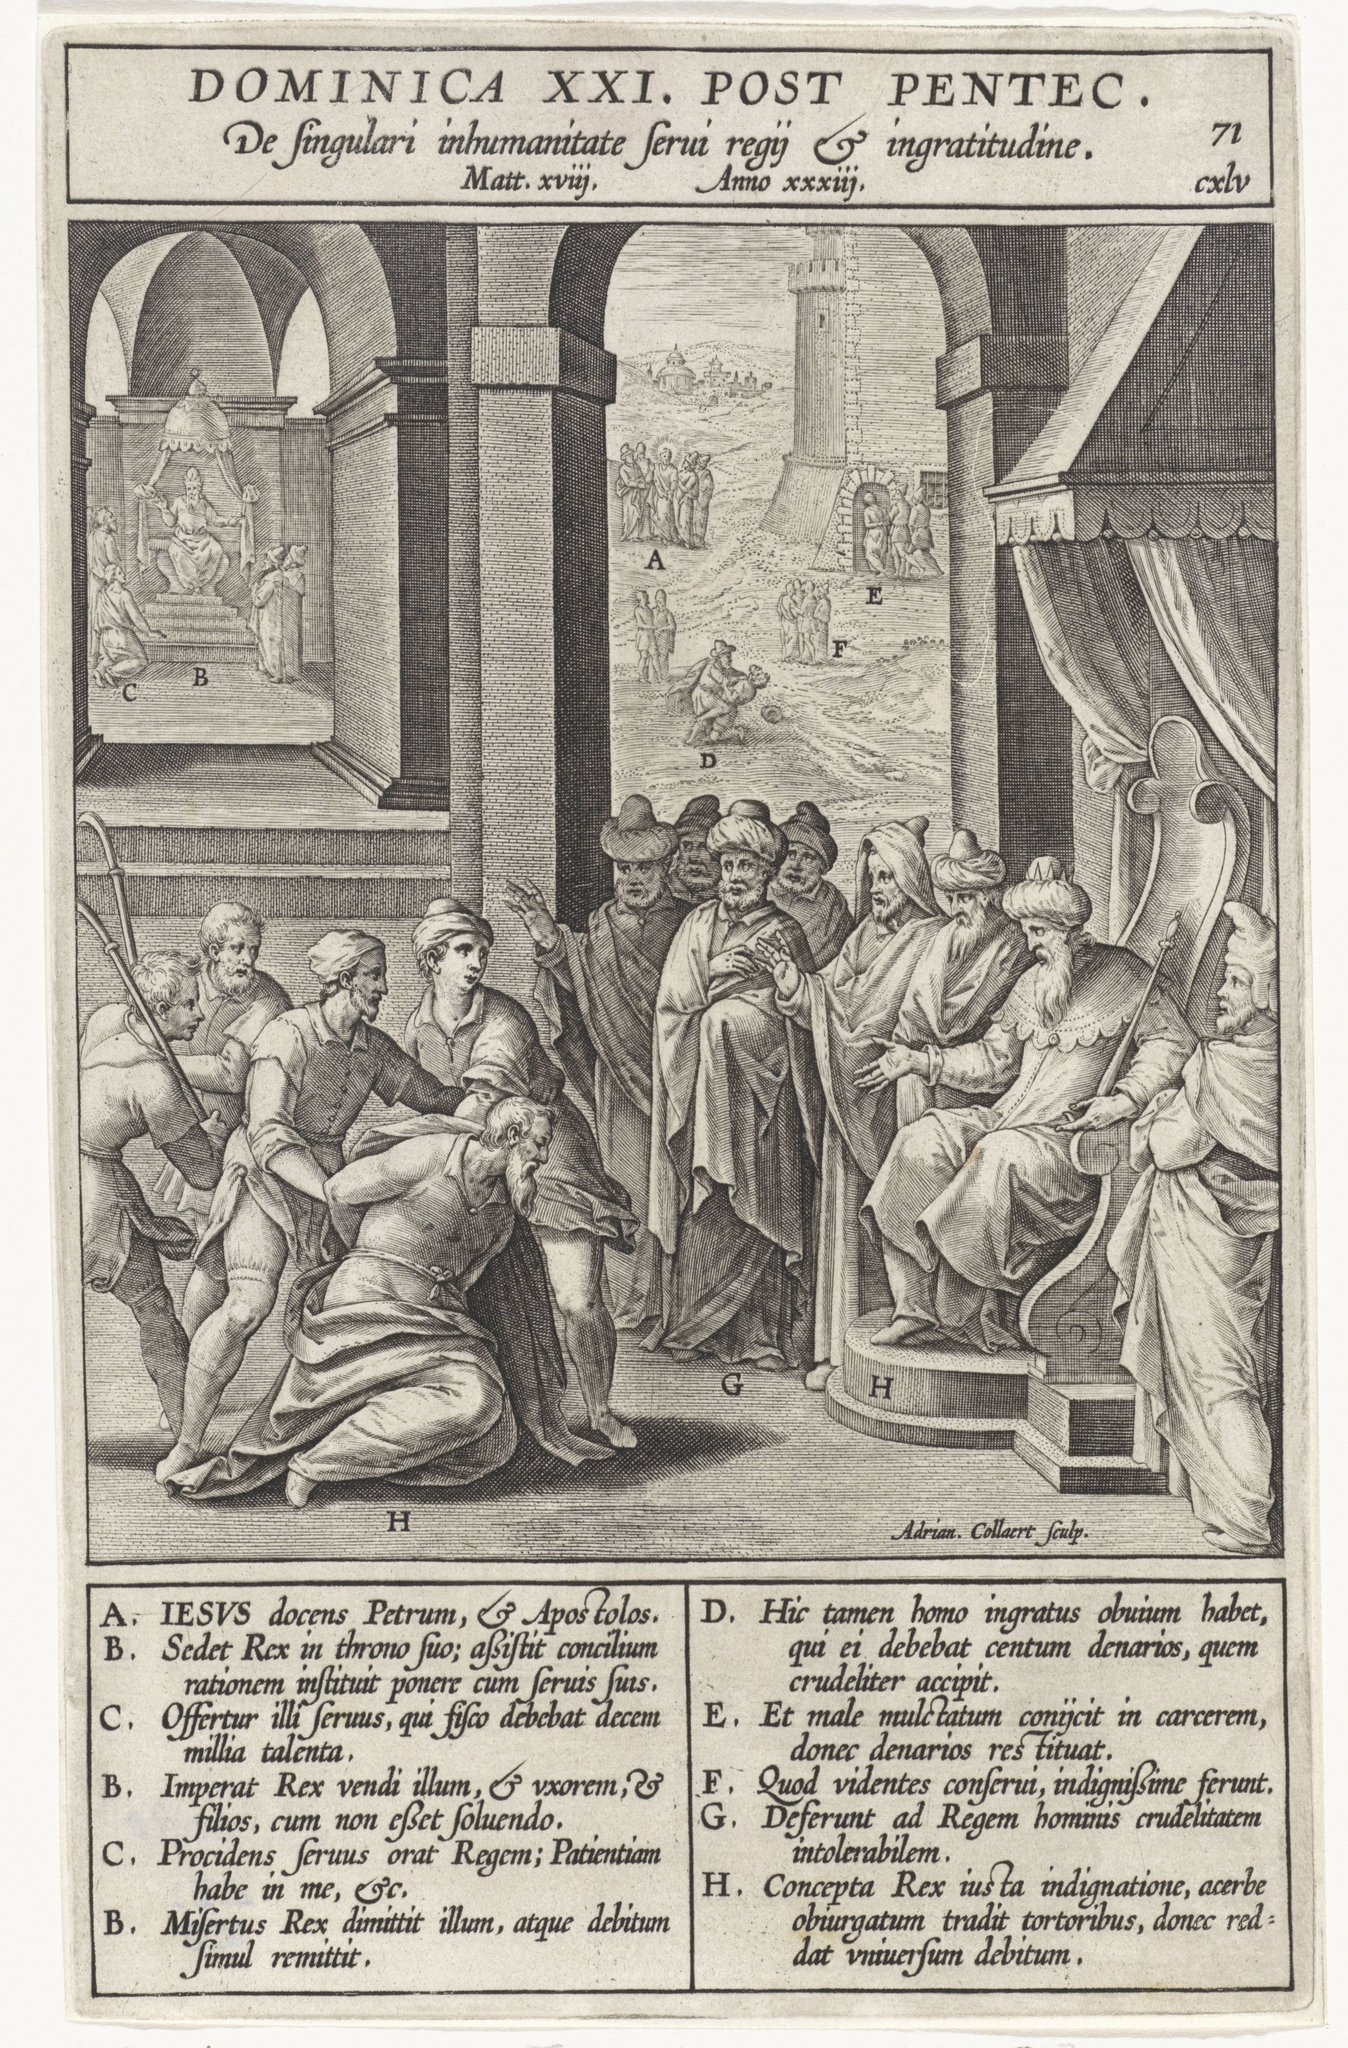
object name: print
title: Dominica XXI. Post Pentec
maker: adriaen collaert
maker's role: draughtsman, print maker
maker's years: 1560-1618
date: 1593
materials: paper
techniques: engraving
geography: antwerp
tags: the unmerciful servant: the king forgives him his debts ~ parable of christ (matthew 18:23-35)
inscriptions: collector's mark: Lugt 2165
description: De ondankbare dienstknecht knielt voor de koning en smeekt hem om hem meer tijd te geven om zijn schuld terug te betalen. De koning kreeg medelijden, liet hem vrij en schold hem het geleende geld kwijt. Bij verschillende elementen uit de voorstelling staan letters die corresponderen met de legenda in de marge.